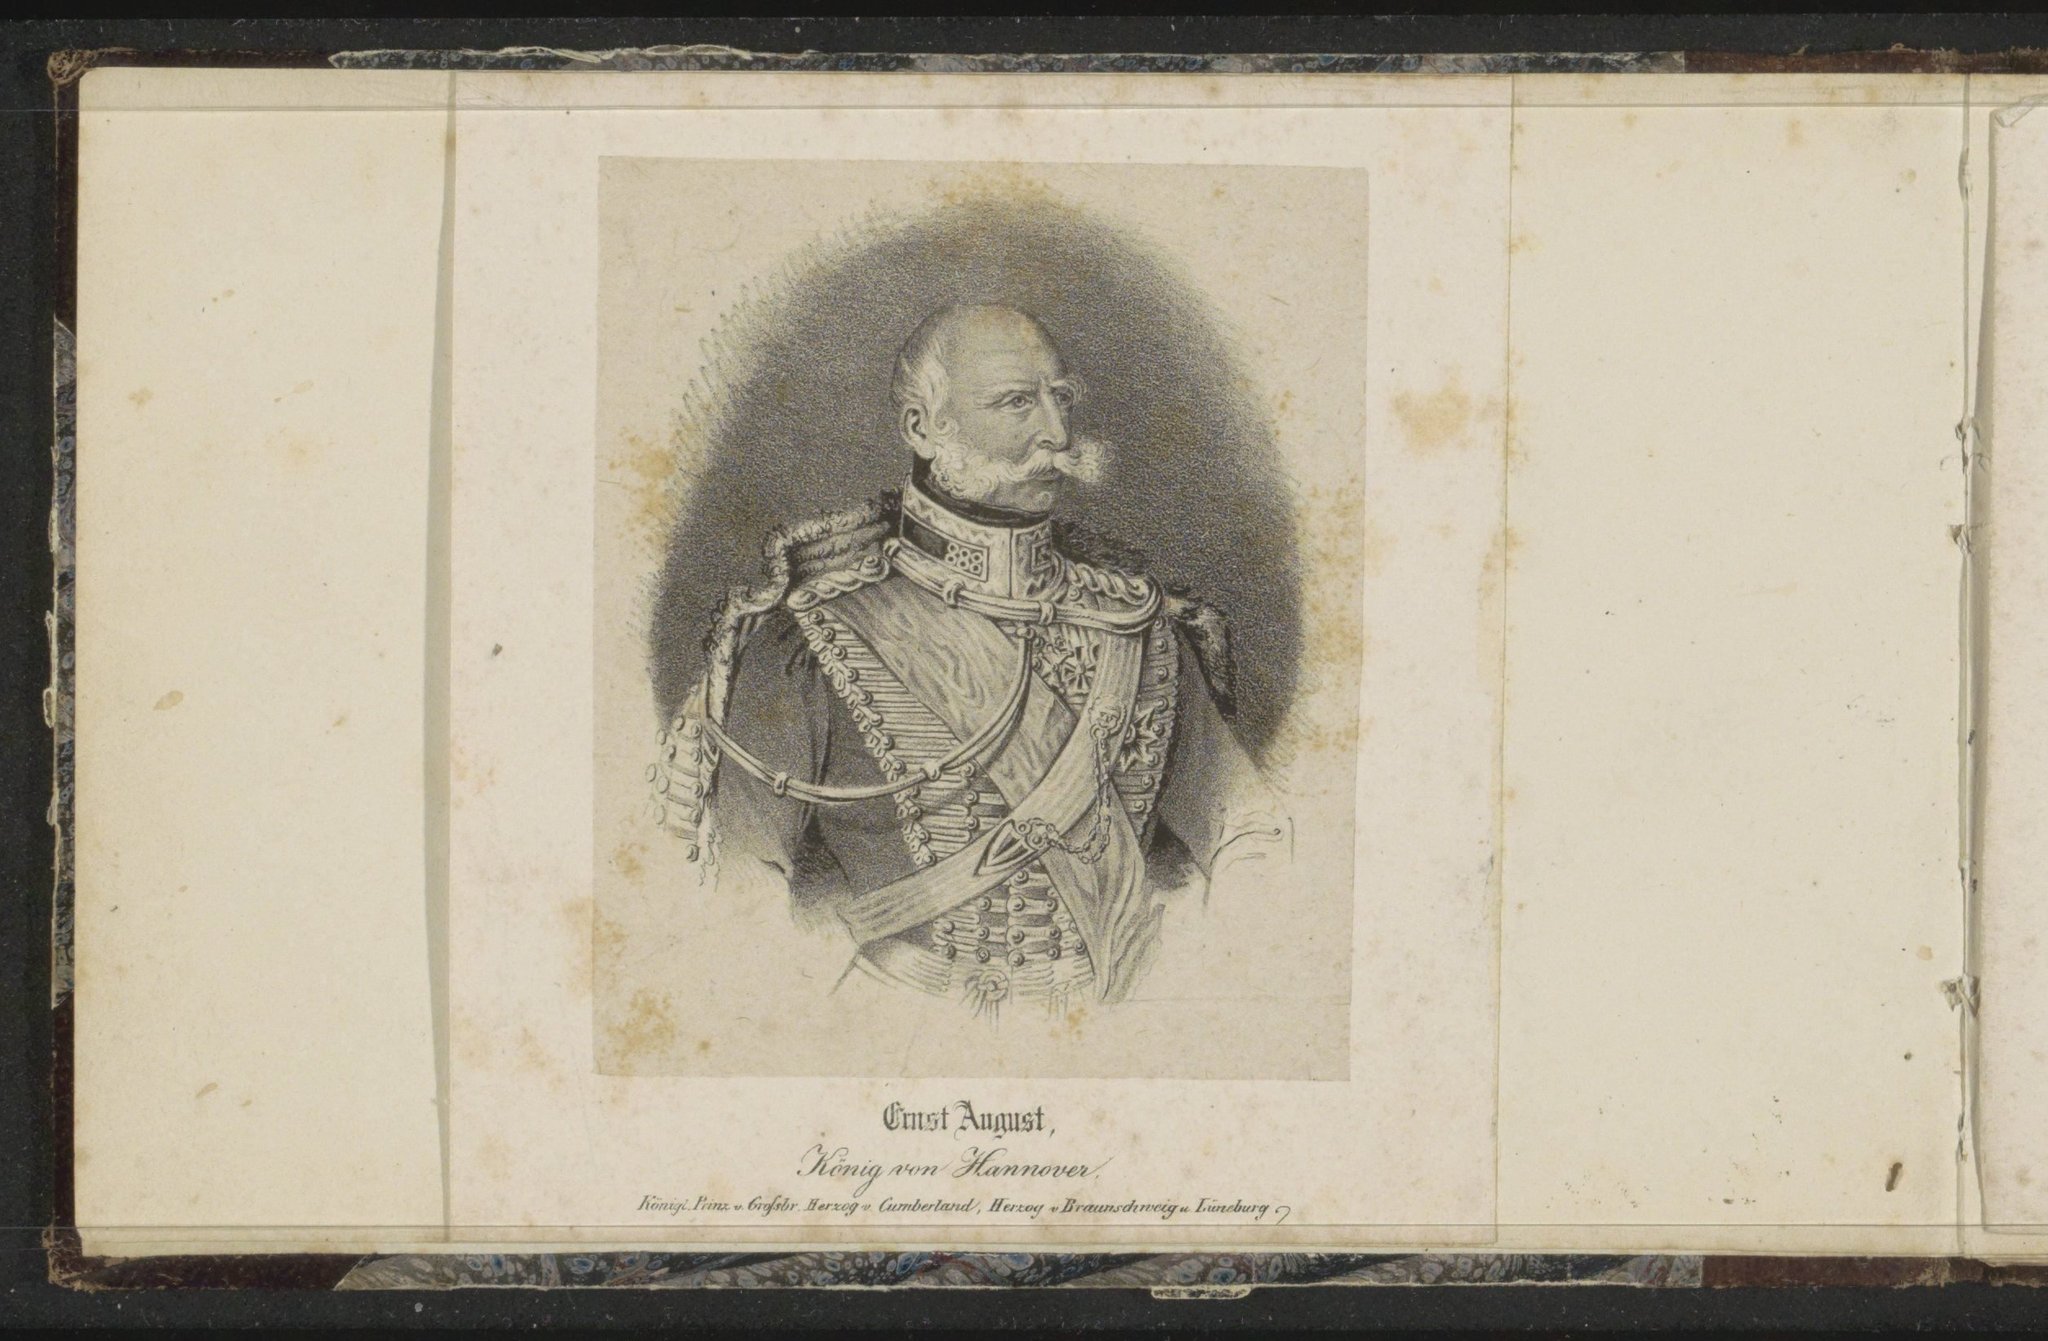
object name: print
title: Portret van Ernst August I, koning van Hannover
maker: Anonymous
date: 1845-1848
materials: paper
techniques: lithograph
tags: historical persons (portraits and scenes from the life)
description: Portret van Ernst August I, koning van Hannover. In de ondermarge zijn naam en volledige titel. Blad 1 verso uit een schetsboek met 61 bladen.